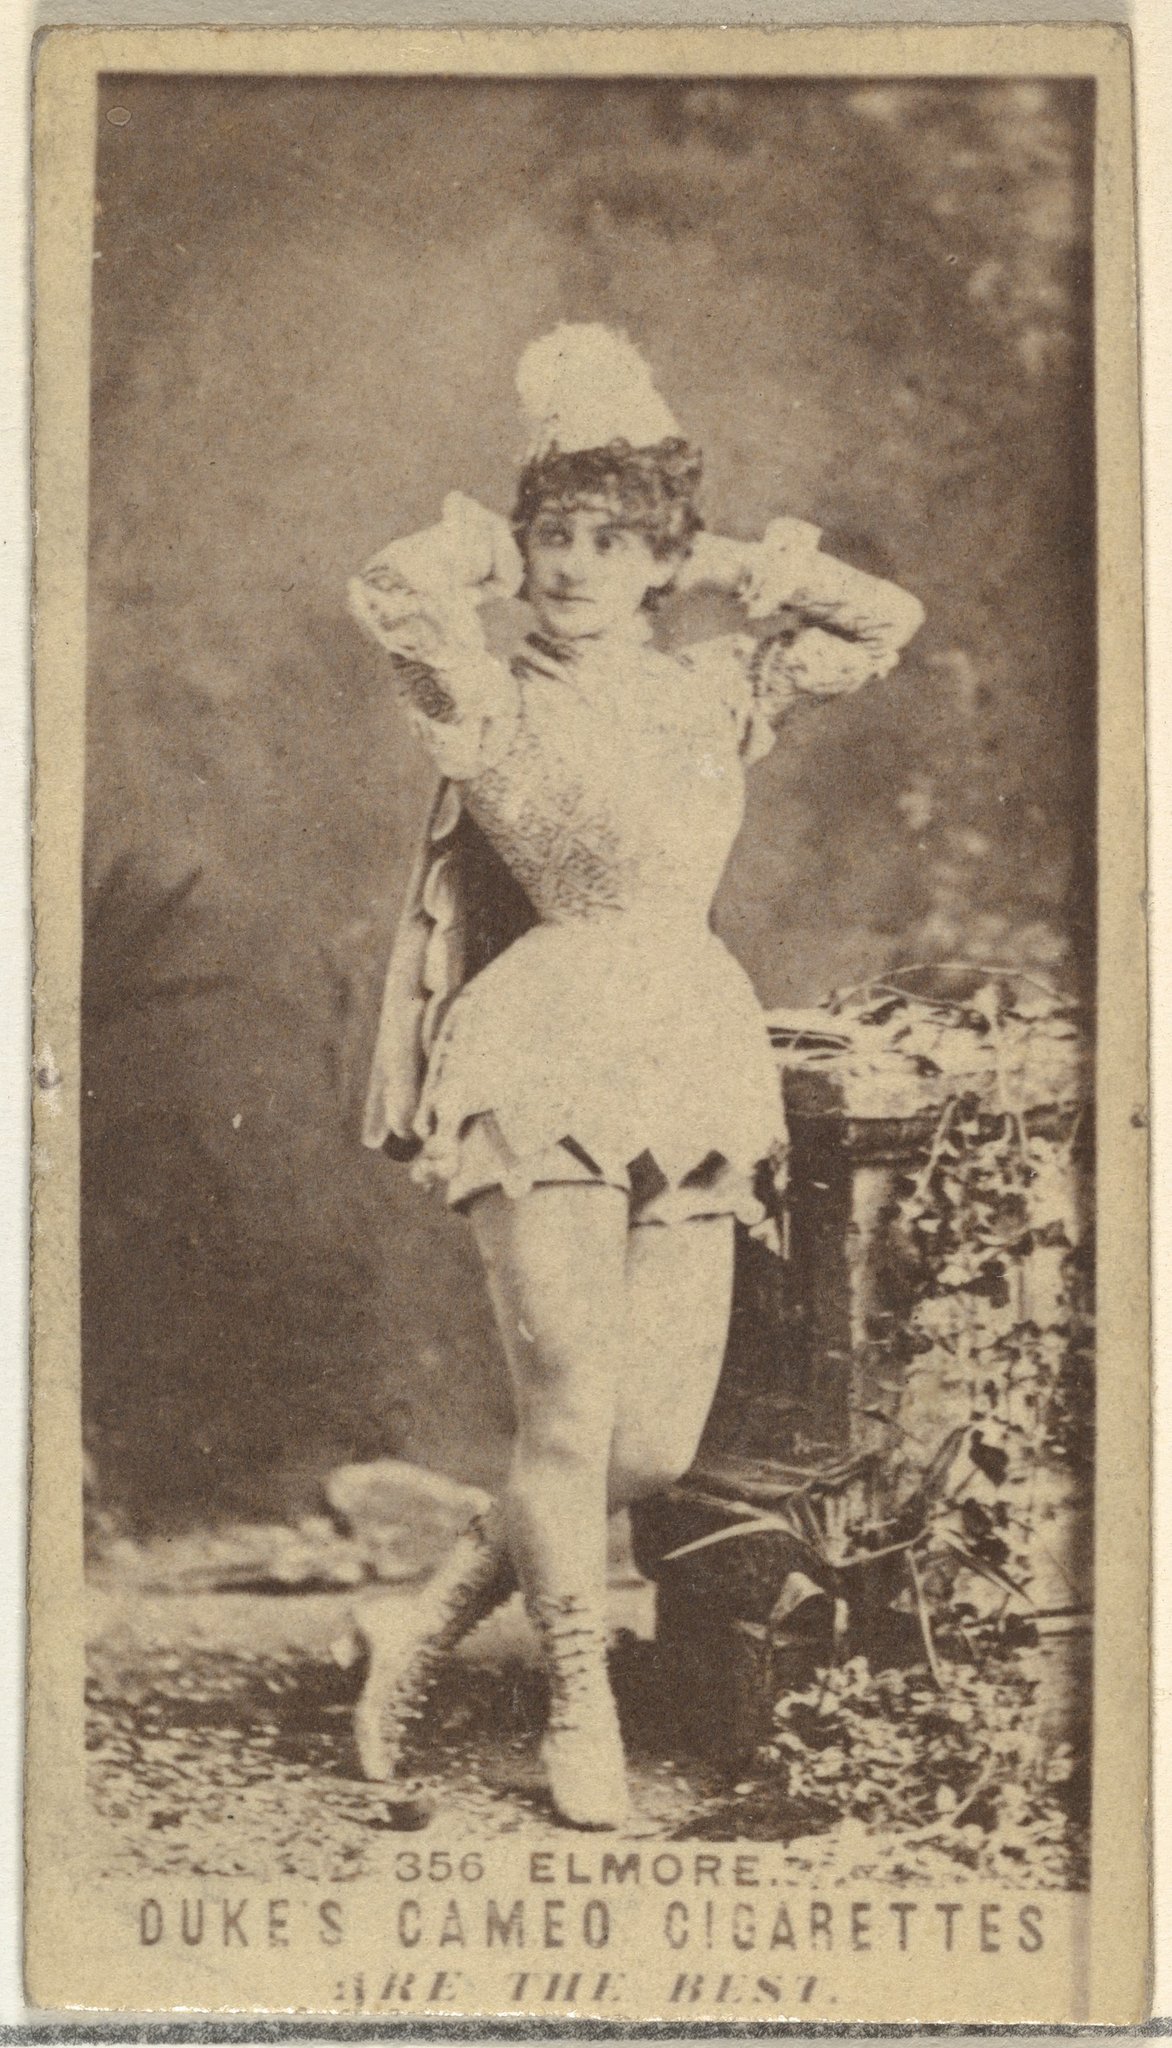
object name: photograph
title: Card Number 356, Miss Elmore, from the Actors and Actresses series (N145-5) issued by Duke Sons & Co. to promote Cameo Cigarettes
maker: w. duke, sons & co.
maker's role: publisher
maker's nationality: american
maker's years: 1870-1920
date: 1880-1889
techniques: albumen silver print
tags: portraits,women,actresses